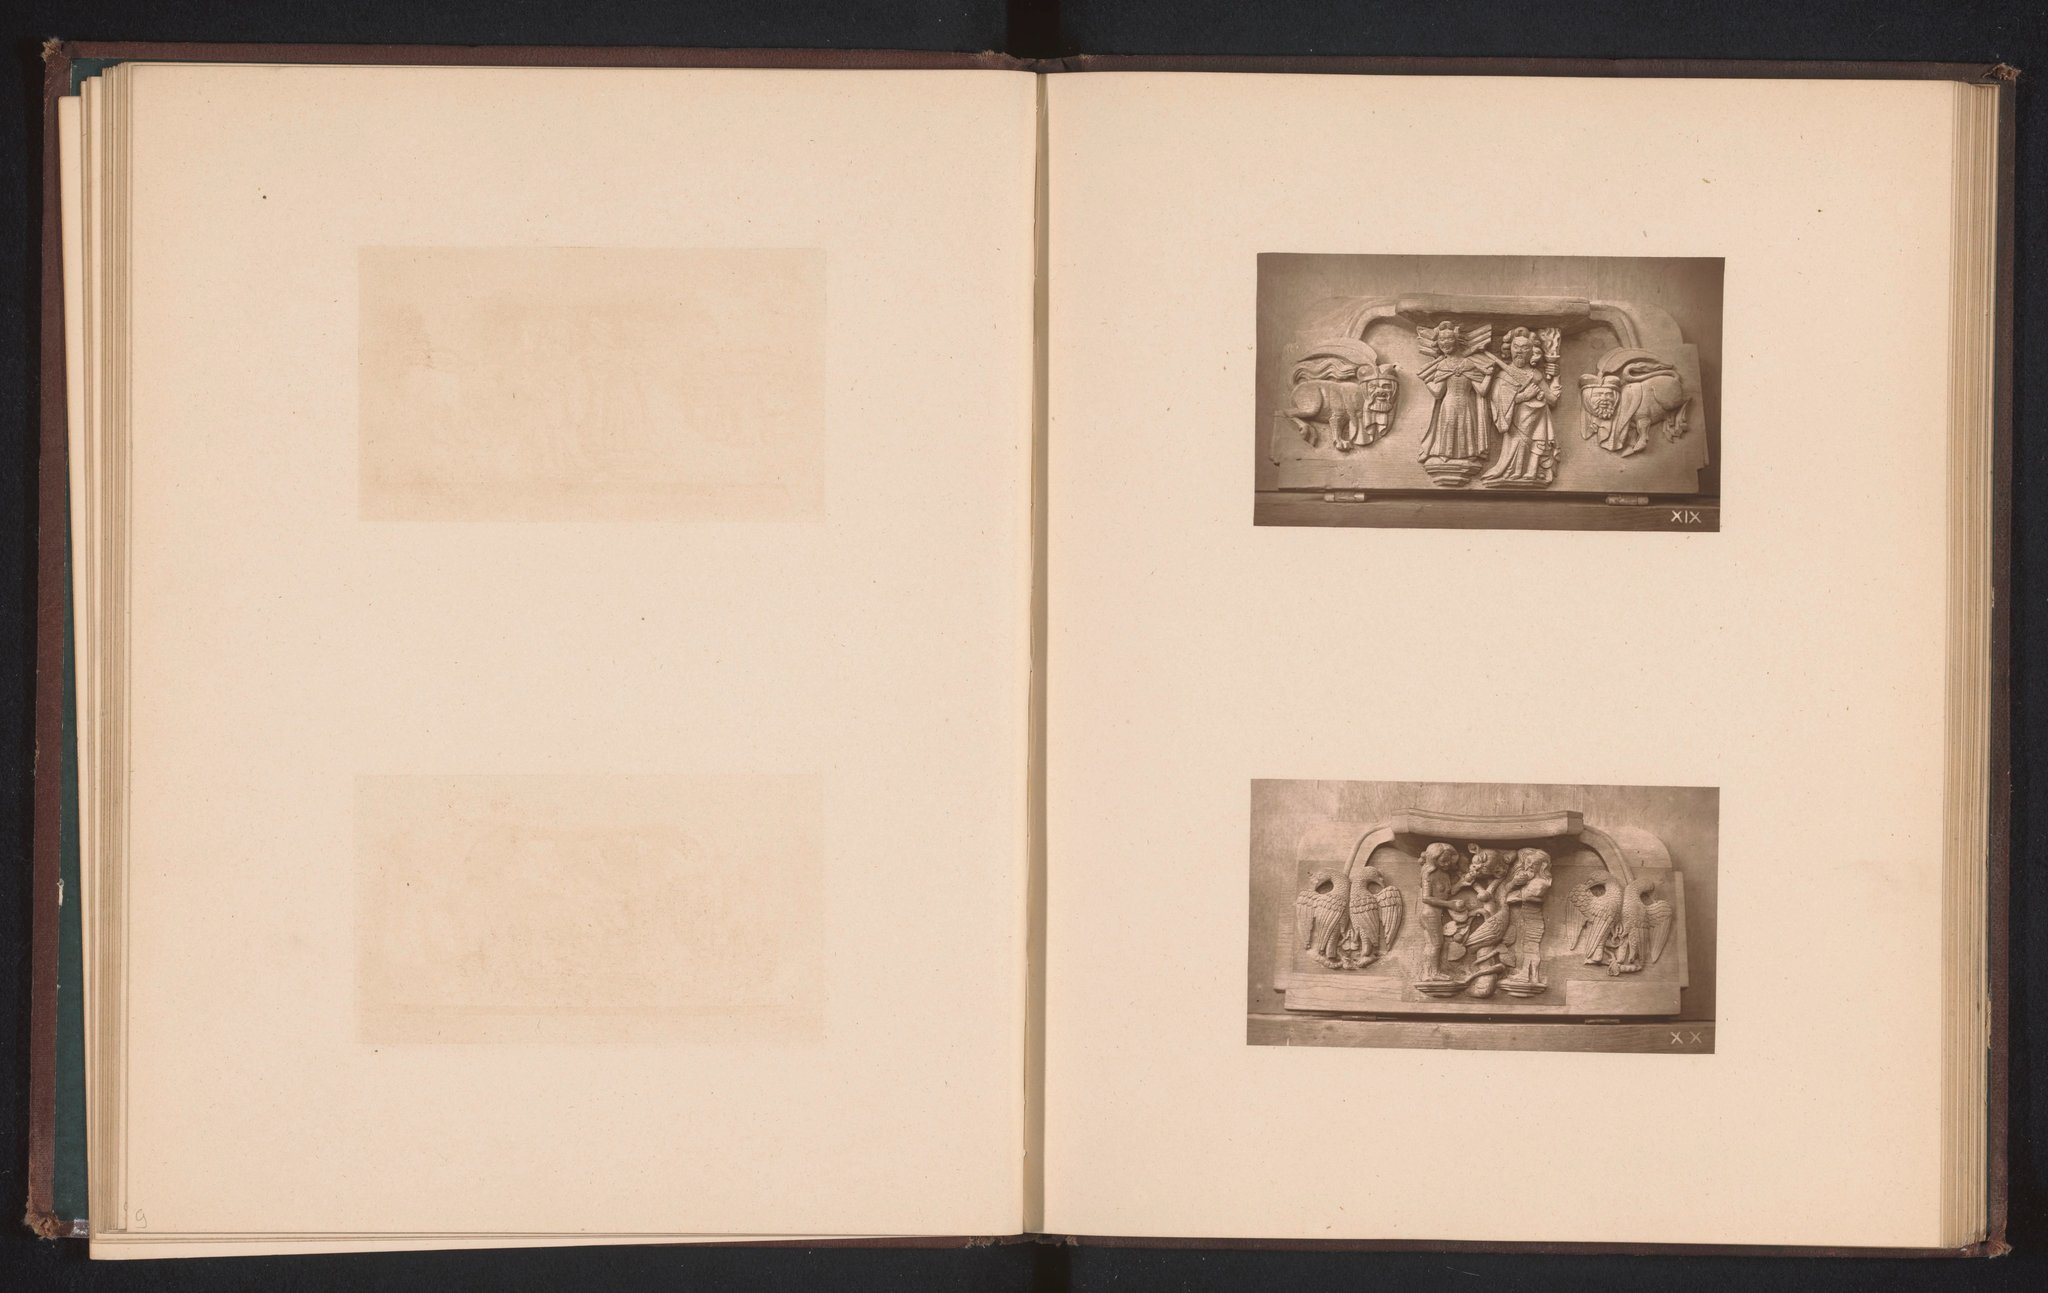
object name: photomechanical print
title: Twee houtsnijwerken in de Kathedraal van Worcester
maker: Anonymous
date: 1863-1873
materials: paper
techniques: woodburytype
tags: carving ~ applied arts, fabulous animals (sometimes wrongly called 'grotesques'); 'mostri' (ripa), adam and eve holding (and possibly eating) the fruit, interior of church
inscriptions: number: ‘XIX (...) XX’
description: Boven een vrouw en een man met een zwaard en fakkel tussen twee fantasiewezens, onder Adam en Eva eten van de boom van de kennis van goed en kwaad tussen vier vogels.